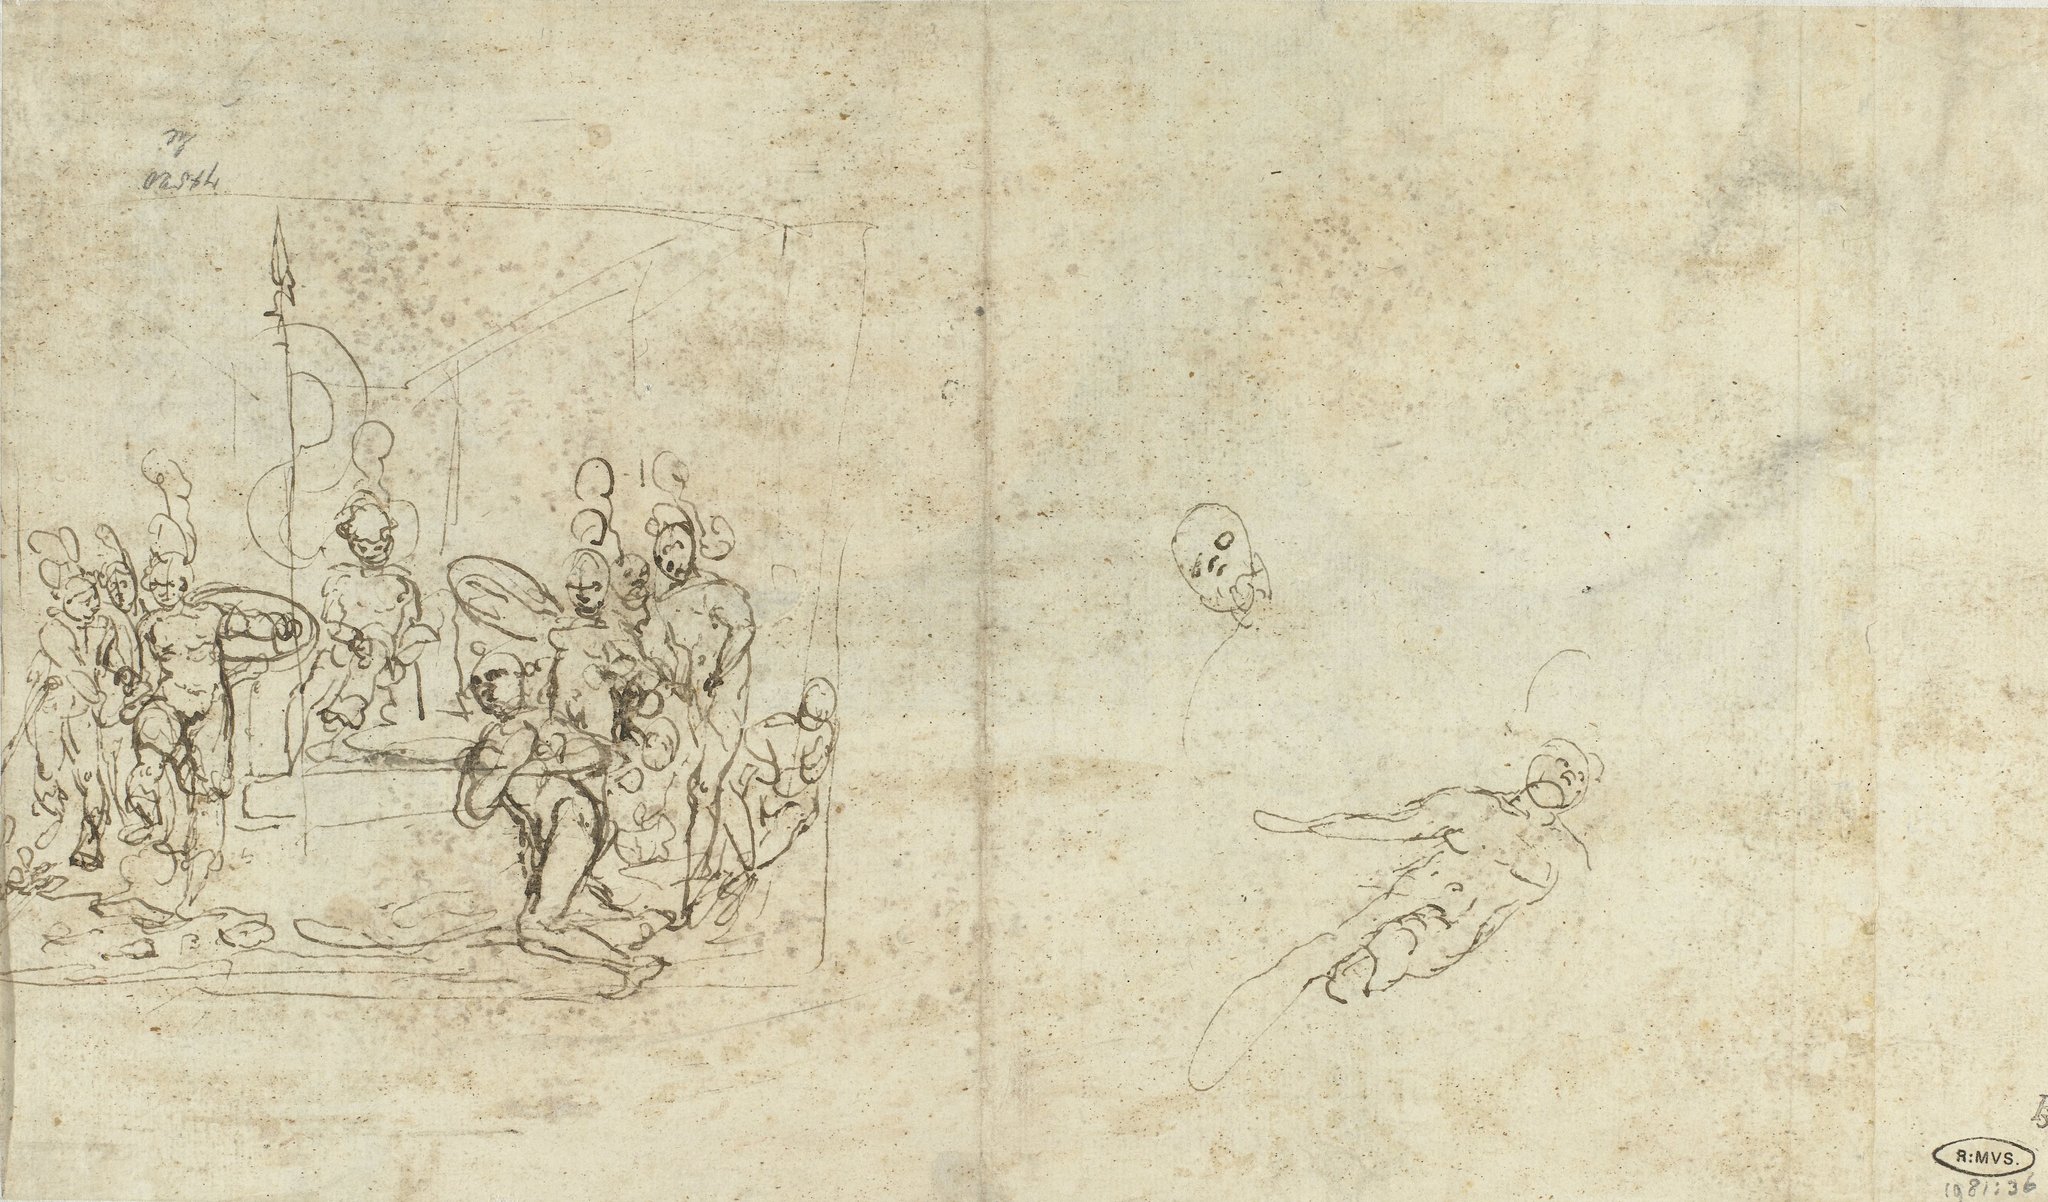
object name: drawing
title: Hoogwaardigheidsbekleder en smekeling, een kop en een lichaam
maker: federico zuccaro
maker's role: draughtsman, print maker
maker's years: 1540-1609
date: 1564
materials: ink, paper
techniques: pen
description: Tafereel met een hoogwaardigheidsbekleder die een smekeling ontvangt, schetsen van een kop en een liggend lichaam.